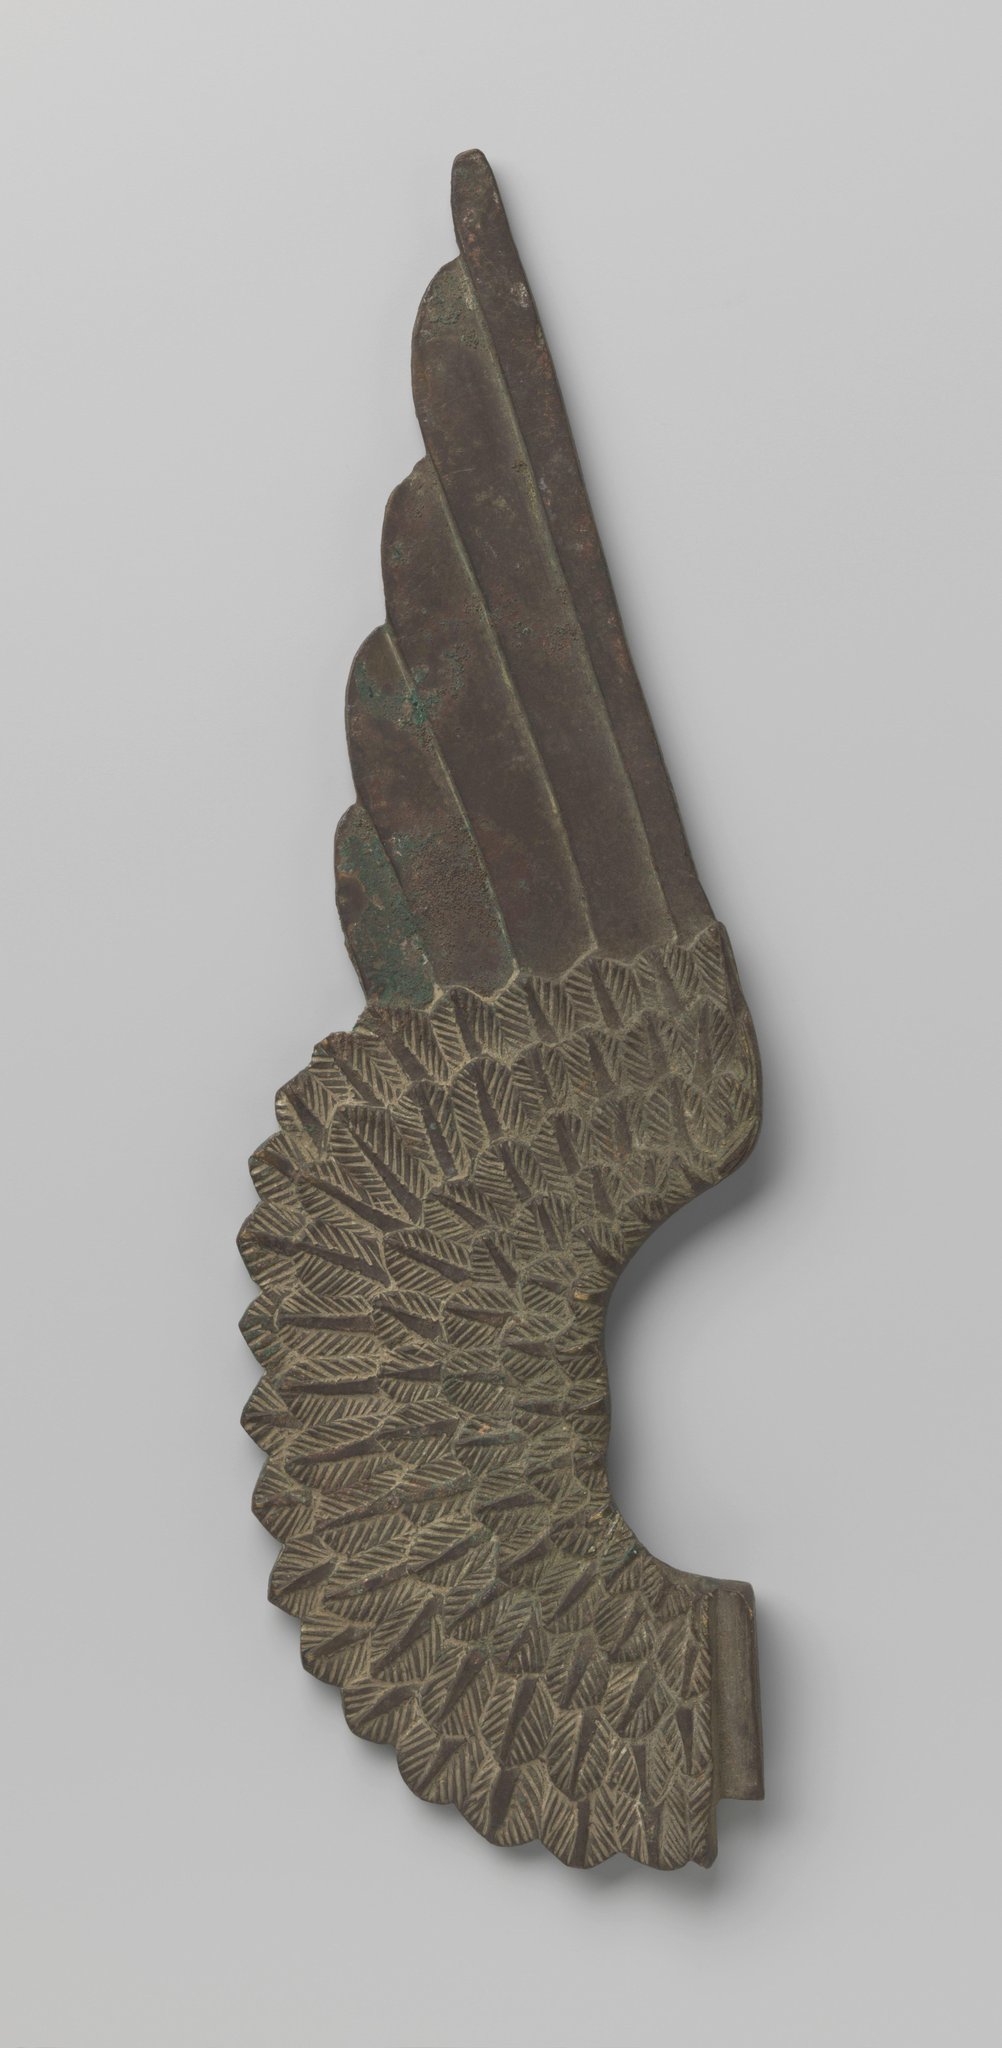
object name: engelenvleugel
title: Engelenvleugel van messing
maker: Anonymous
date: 1400-1500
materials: brass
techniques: casting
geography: southern netherlands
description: Bodemvondst: De vleugels zijn waarschijnlijk opgegraven bij de Grote of St.-Jacobskerk te Den Haag in 1857, samen met de kaarsenkroon (BK-NM-9387-A). In de brief van 5 mei 1891 van de directeur van het Nederlandsch Museum welke betrekking heeft op de aankoop van deze collectie, behoren deze vleugels vermoedelijk tot de 'losse armen en andere fragmenten.' Wellicht zijn deze vleugels onderdelen geweest van engelenfiguren (met lijdenswerktuigen?) die op een lichtboog (of herse) hebben gestaan.